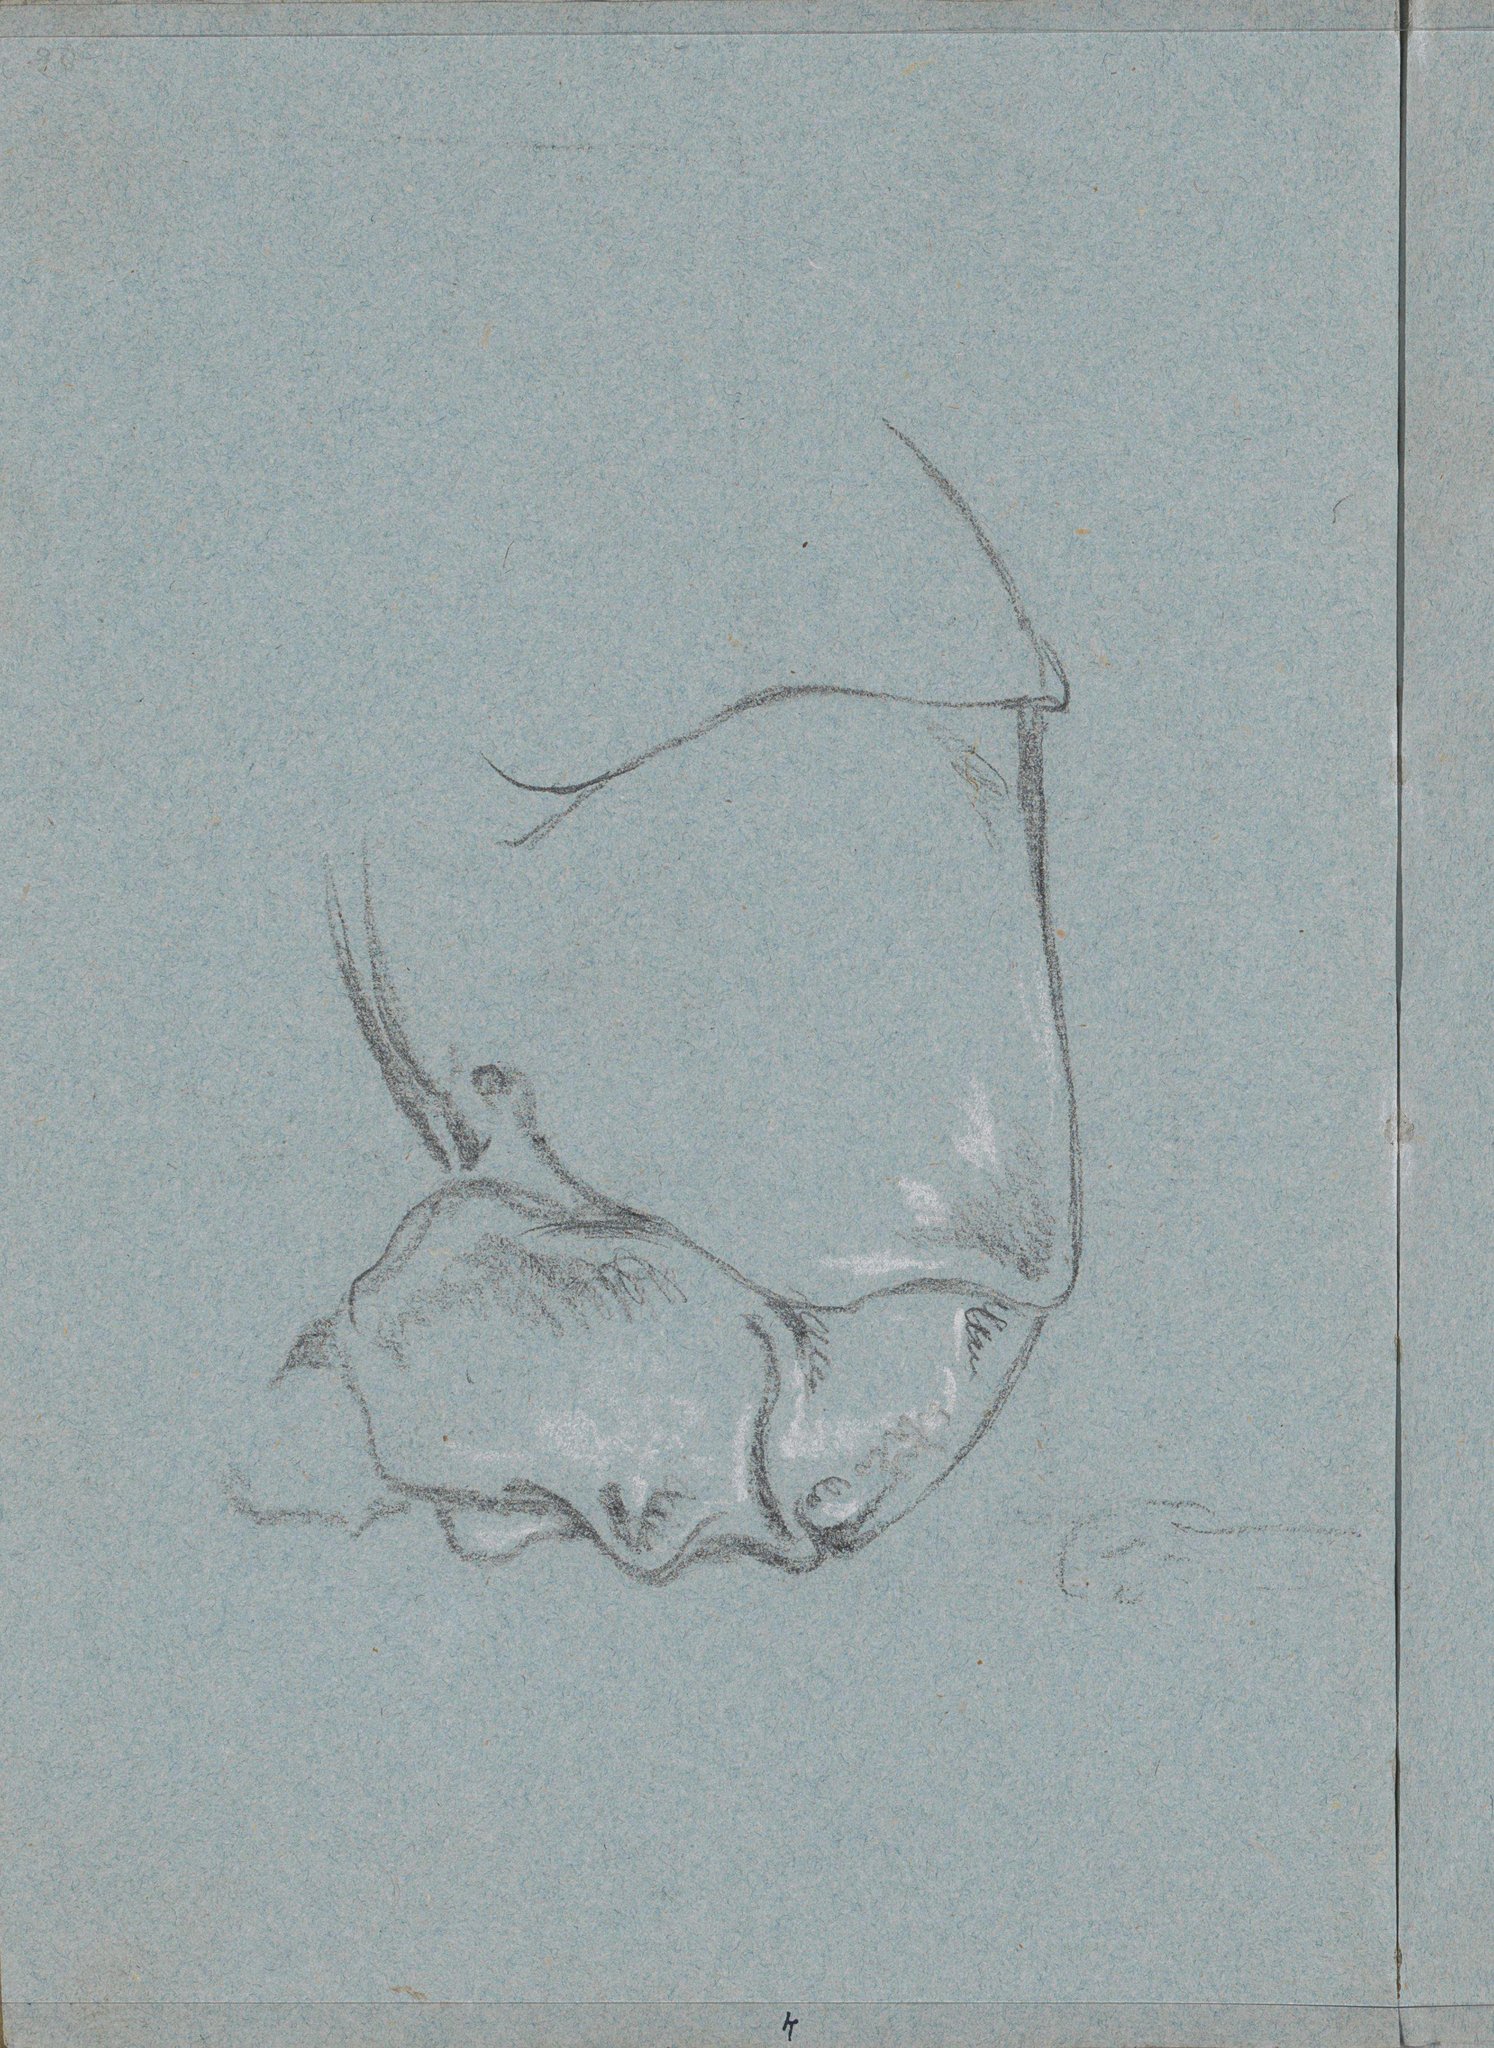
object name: sketchbook leaf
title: Achterste deel van neushoorn Clara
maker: lorenzo baldissera tiepolo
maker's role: draughtsman, print maker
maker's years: 1736-1776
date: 1751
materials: chalk, paper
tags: london, hoofed animals: rhinoceros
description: Studie naar de neushoorn Clara, die vanaf 1746 een rondreis door Europa maakte (zie documentatie).